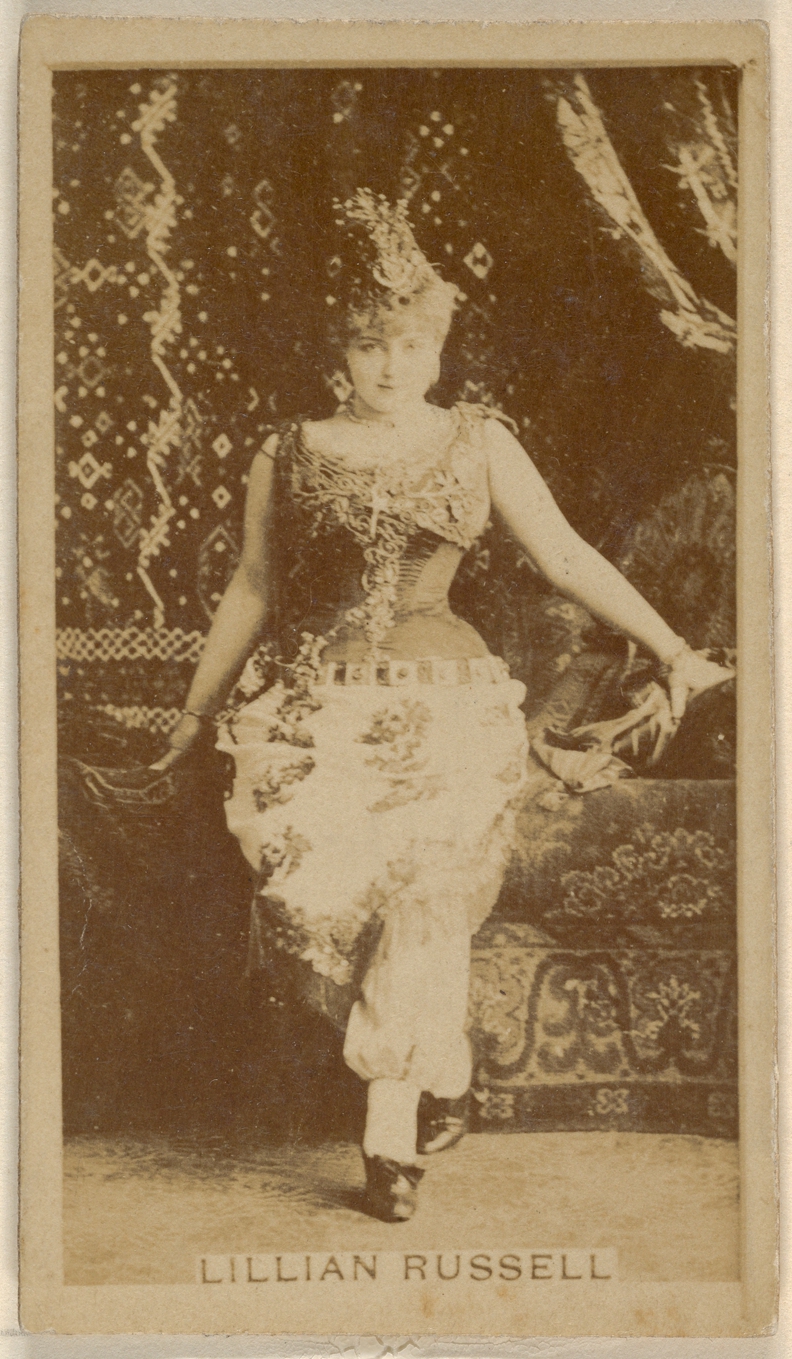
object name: photograph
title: Lillian Russell, from the Actors and Actresses series (N45, Type 8) for Virginia Brights Cigarettes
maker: allen & ginter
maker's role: publisher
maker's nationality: american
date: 1888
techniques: albumen silver print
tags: portraits,women,actresses